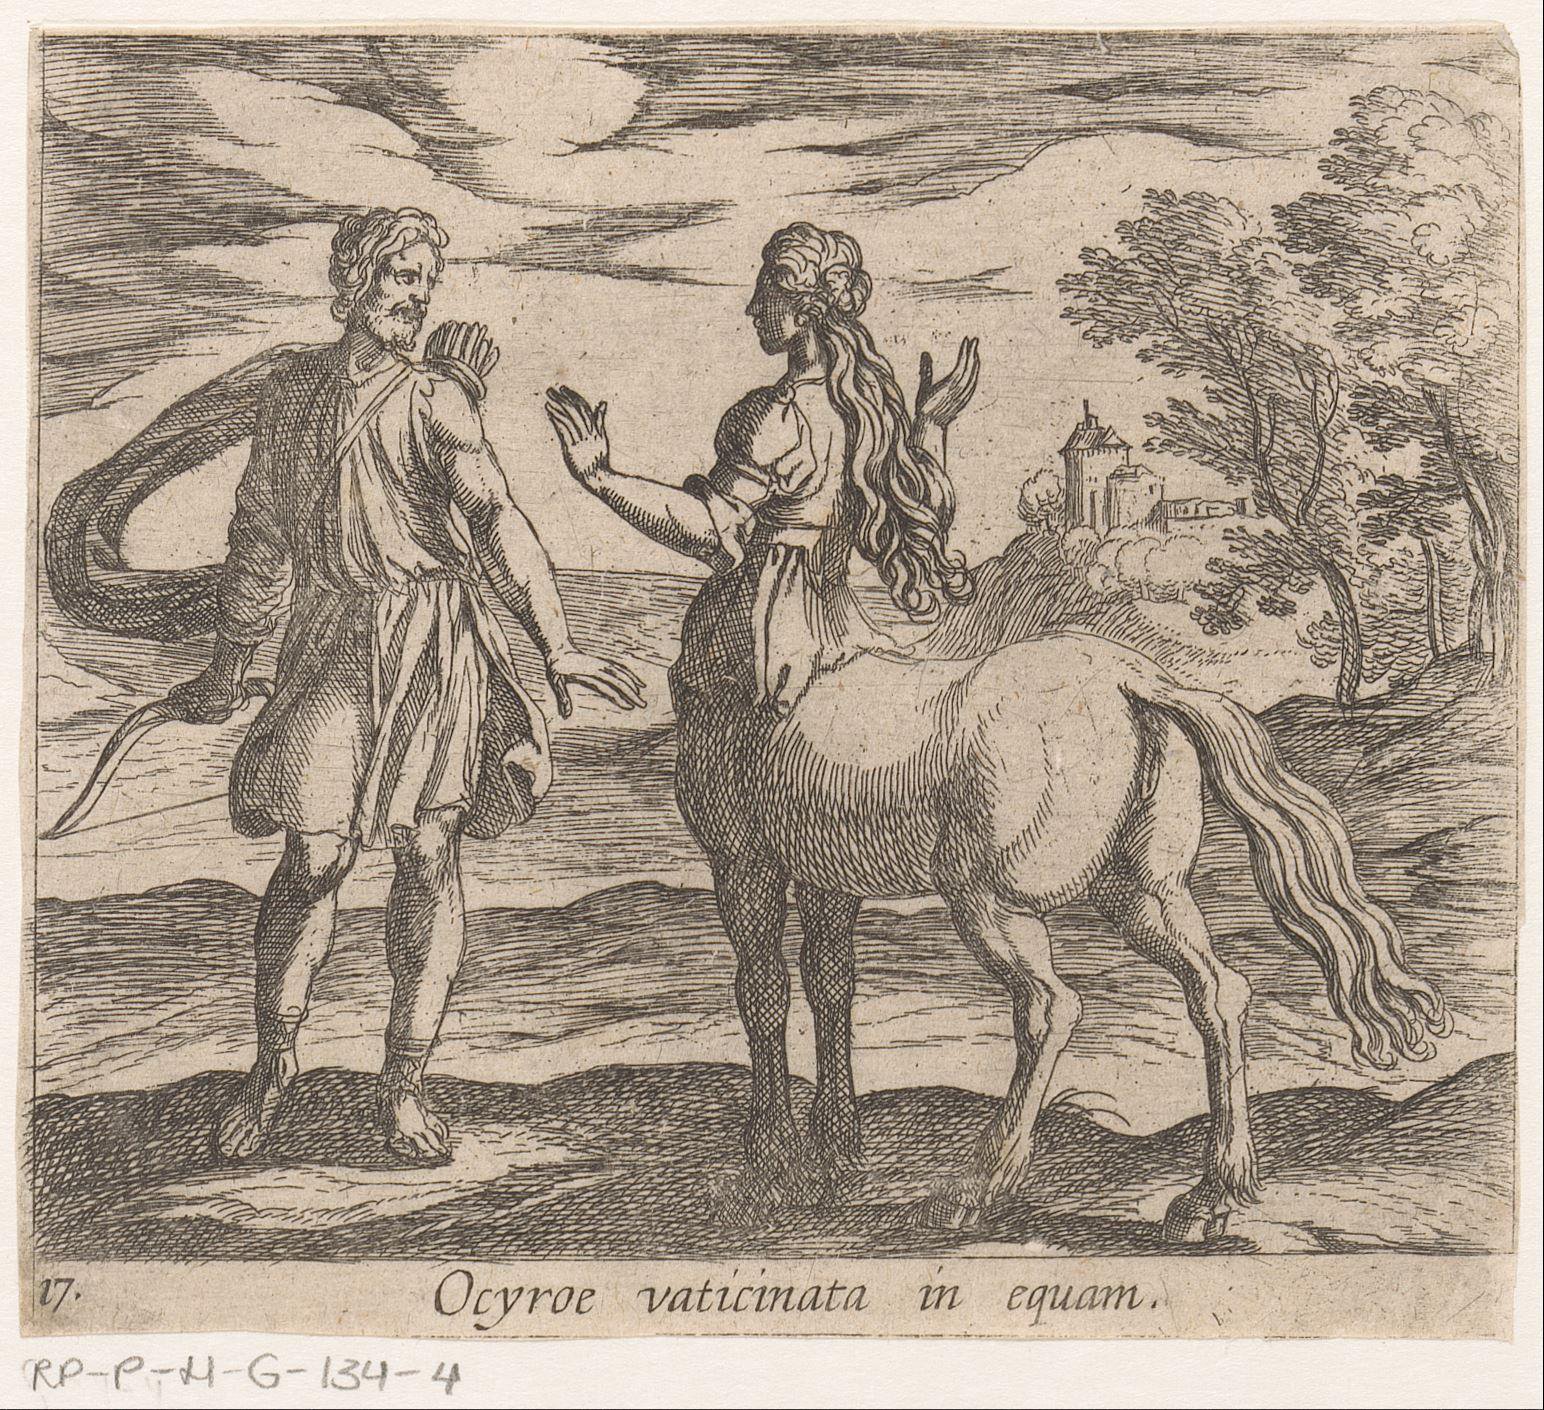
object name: print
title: Ocyrhoe wordt in een paard veranderd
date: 1606-1638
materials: paper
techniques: etching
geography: italy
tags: ocyroe changed into a mare: when she is foretelling the fates of her father chiron and the young aesculapius, ocyroe is changed into a mare (ovid, metamorphoses ii 657)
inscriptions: collector's mark: ‘Hinloopen’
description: Ocyrhoe, de dochter van Chiron, wordt in een paard veranderd, na voorspeld te hebben hoe de toekomst van Asclepius en haar vader zal zijn. Titel in het Latijn in ondermarge.